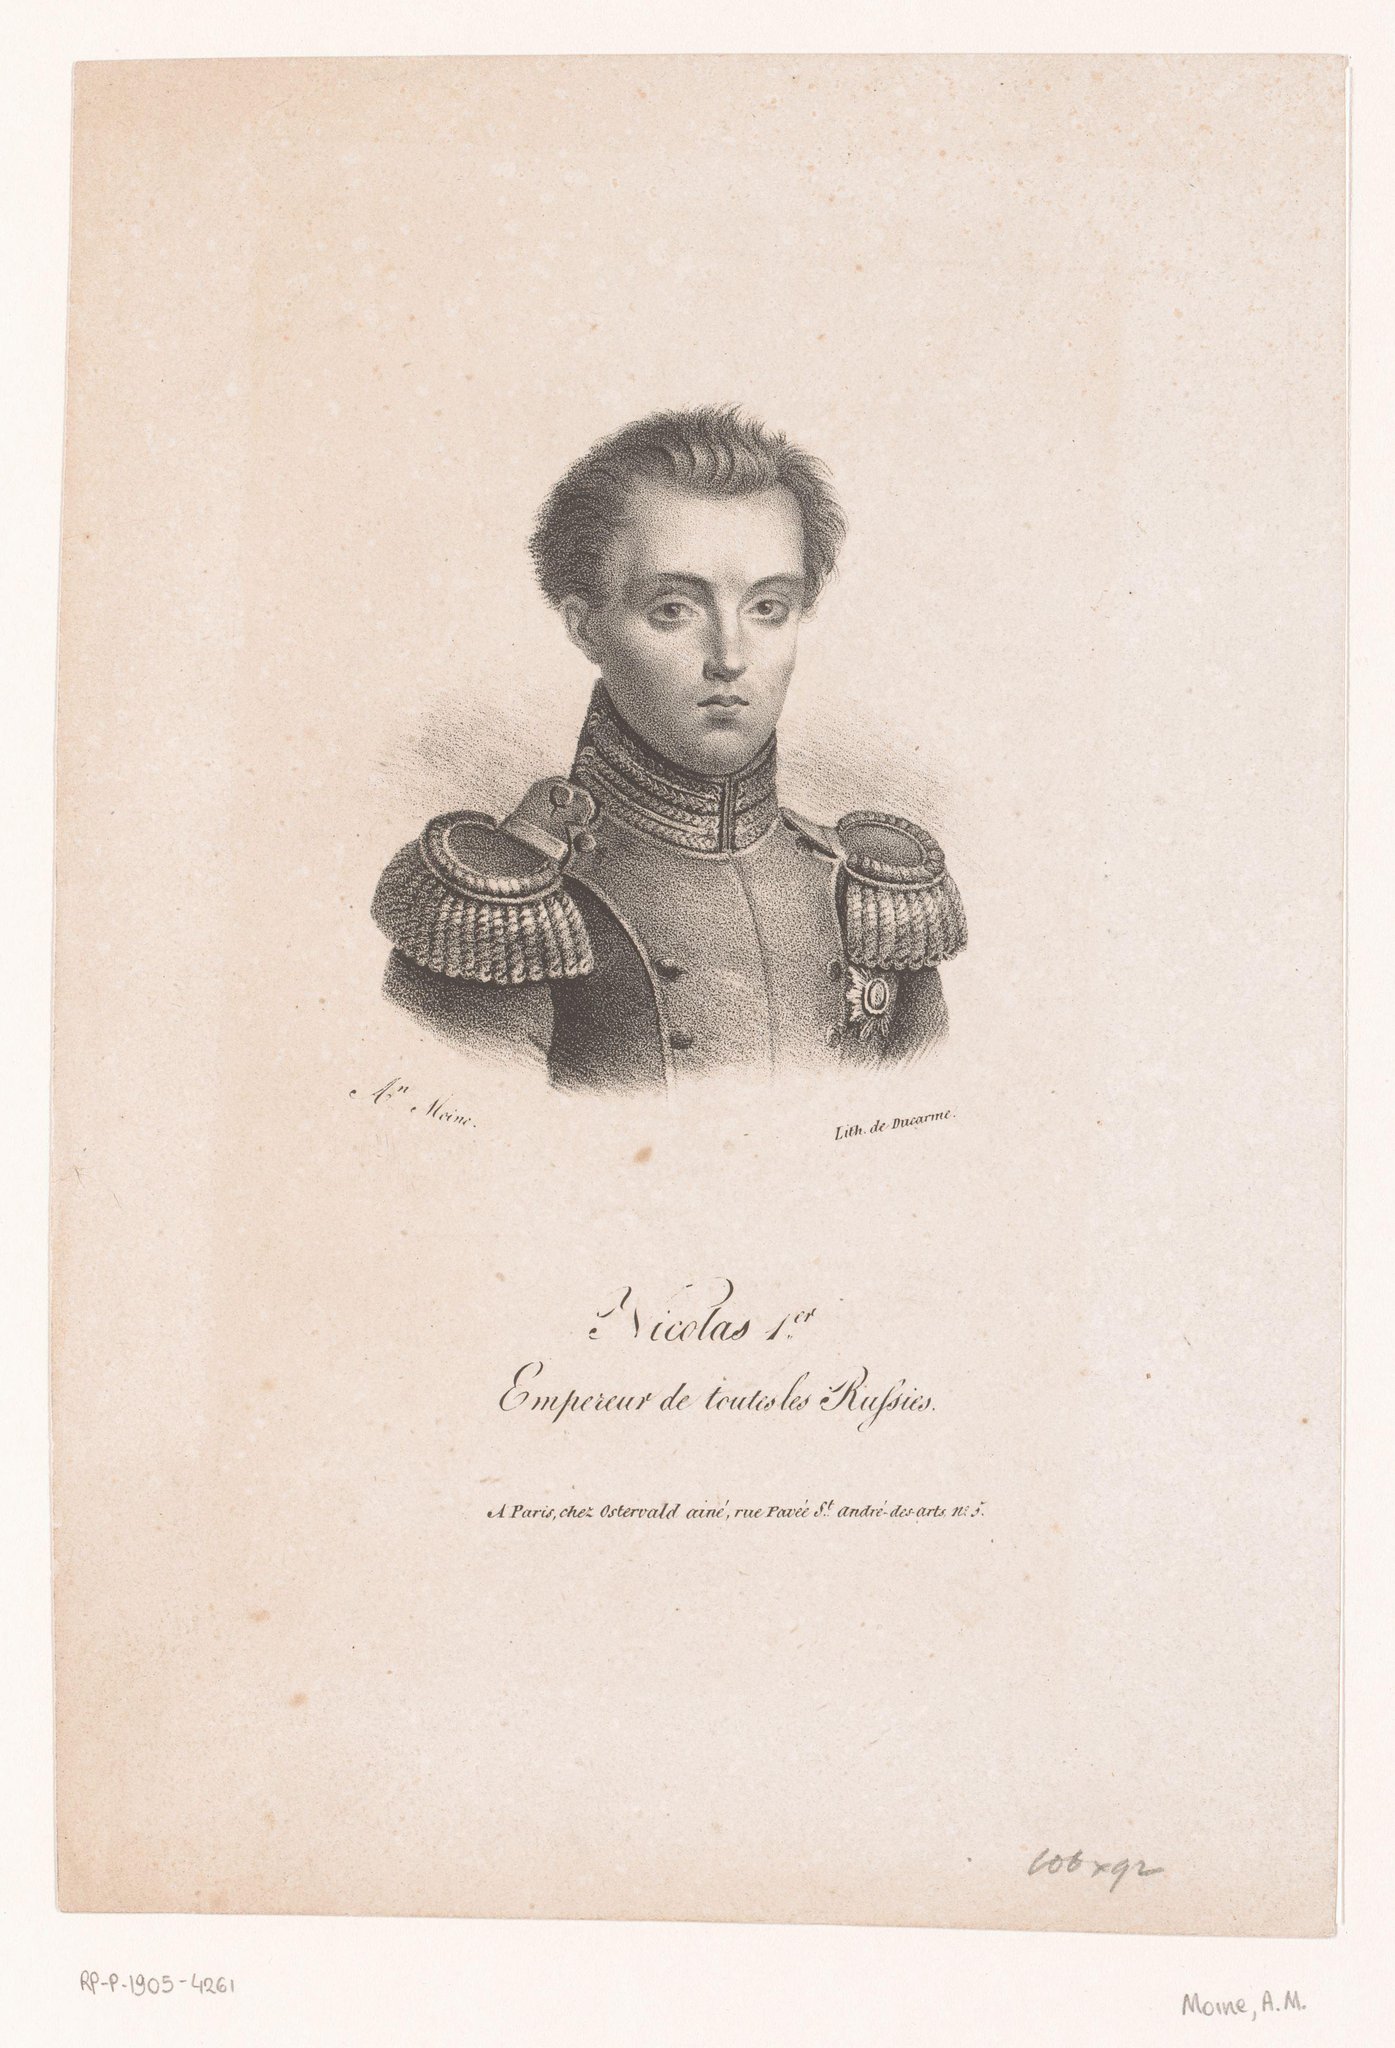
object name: print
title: Portret van Nicolaas I Pavlovitsj, tsaar van Rusland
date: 1820-1829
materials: paper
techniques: lithograph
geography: paris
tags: historical persons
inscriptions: collector's mark: Lugt 2228